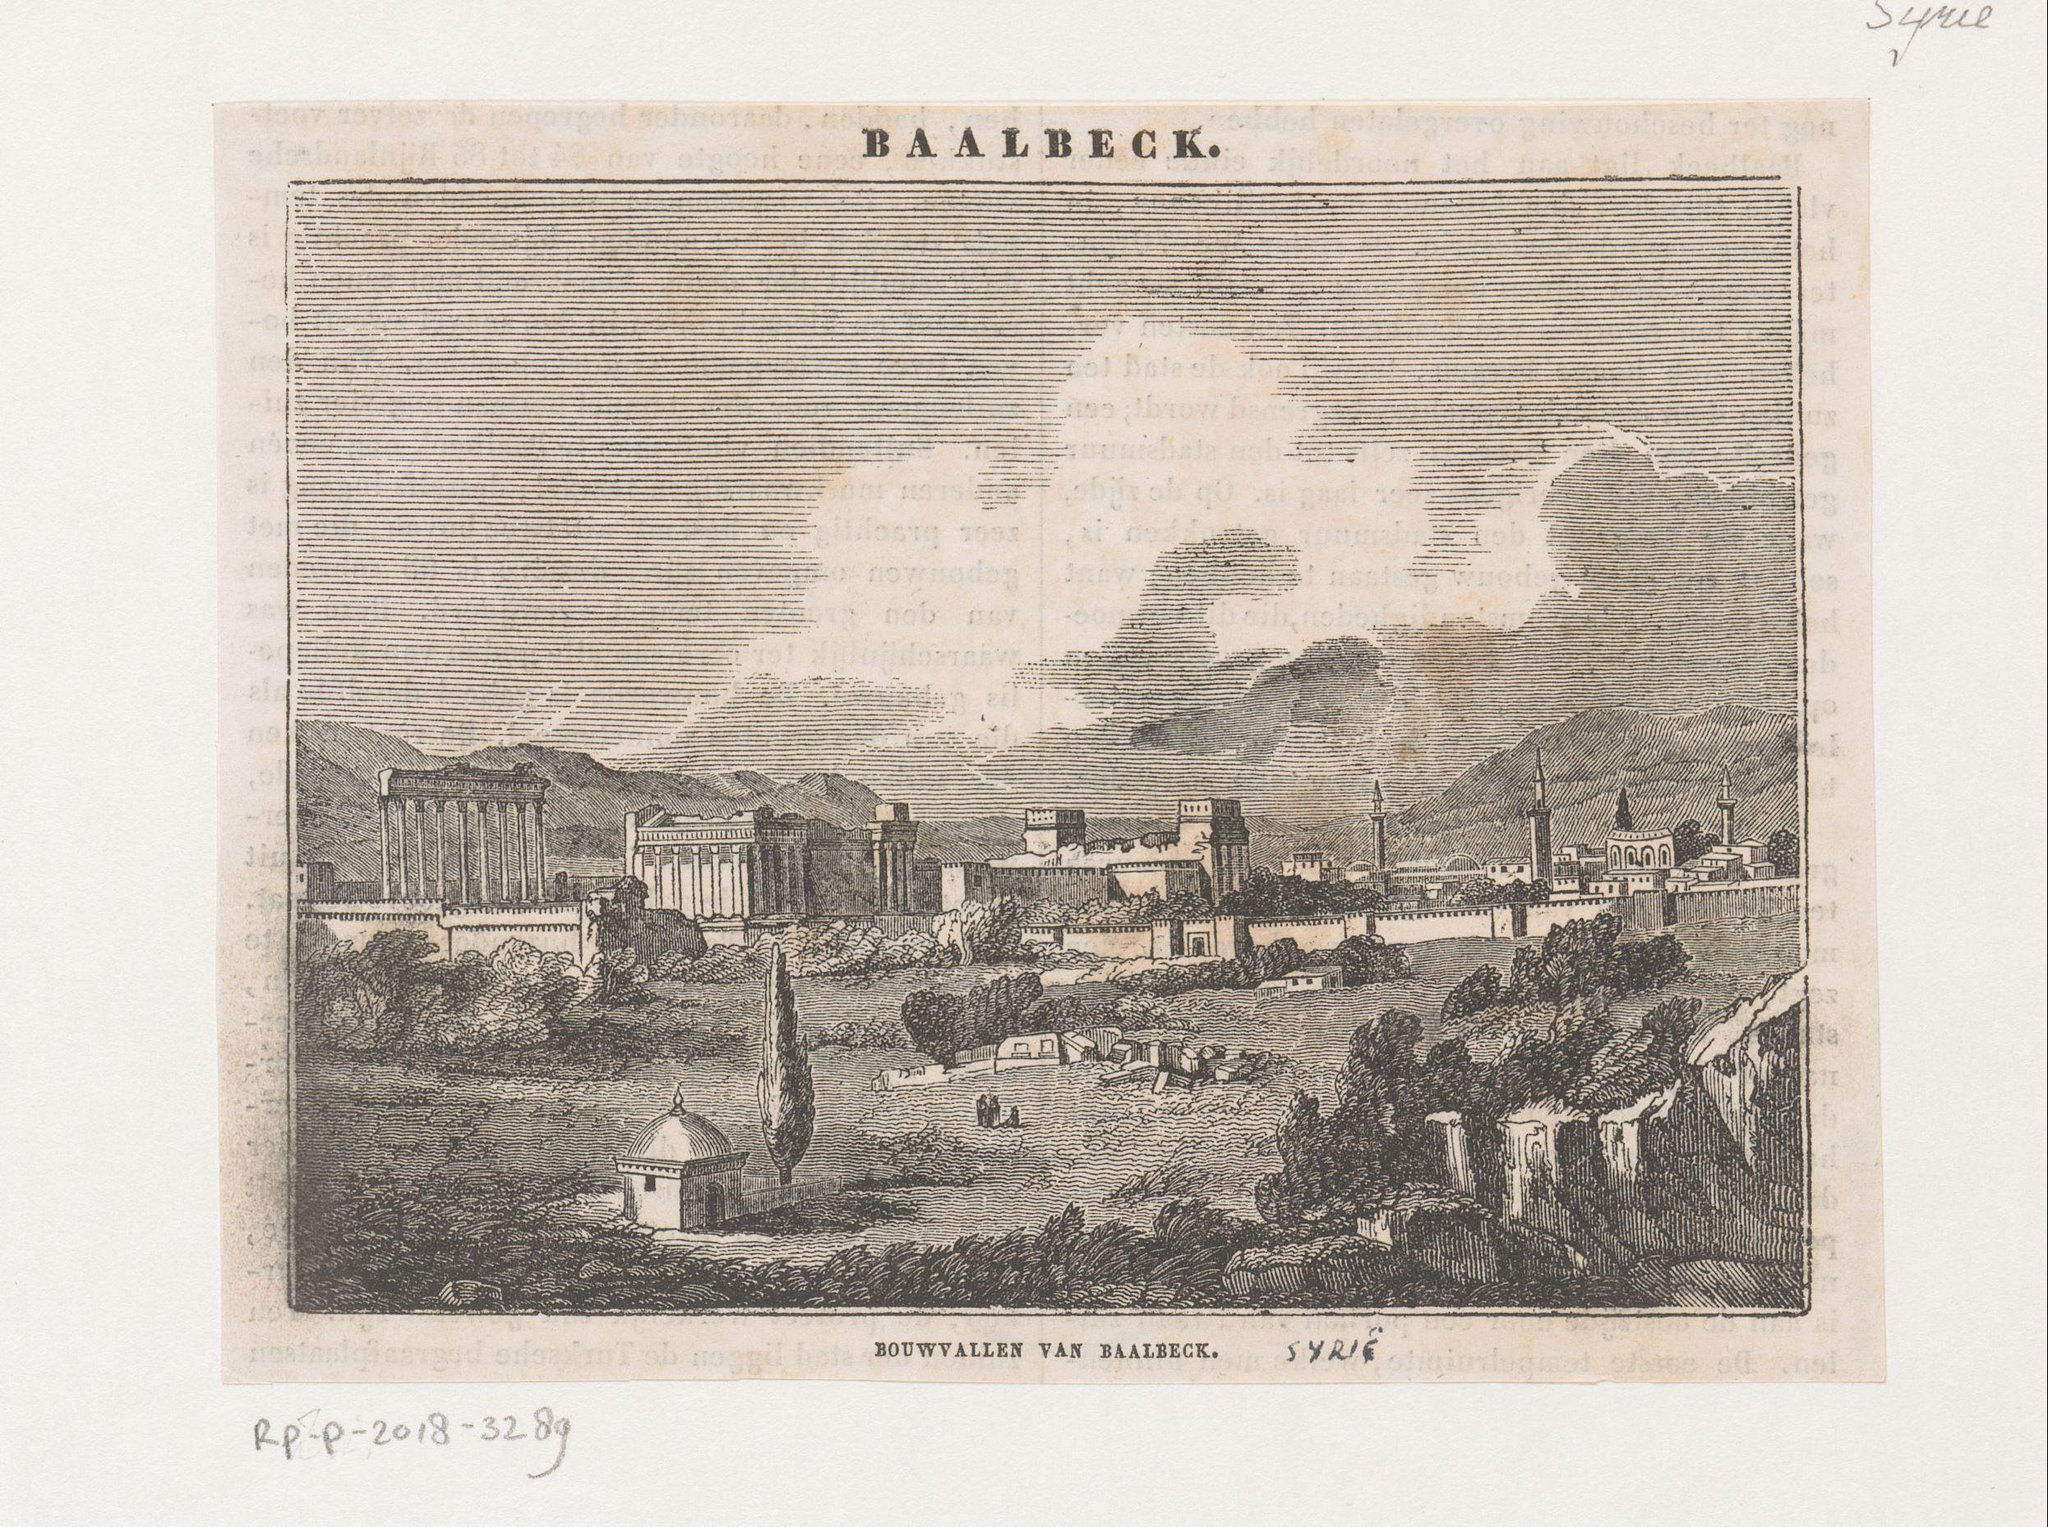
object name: print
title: Ruïnes van Baalbek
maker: Anonymous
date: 1837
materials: paper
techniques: letterpress printing, engraving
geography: amsterdam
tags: landscape with ruins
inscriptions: collector's mark: Lugt 2228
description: Prent uit: Nederlandsch Magazijn, ter verspreiding van algemeene en nuttige kundigheden 4 (1837), p. 185.